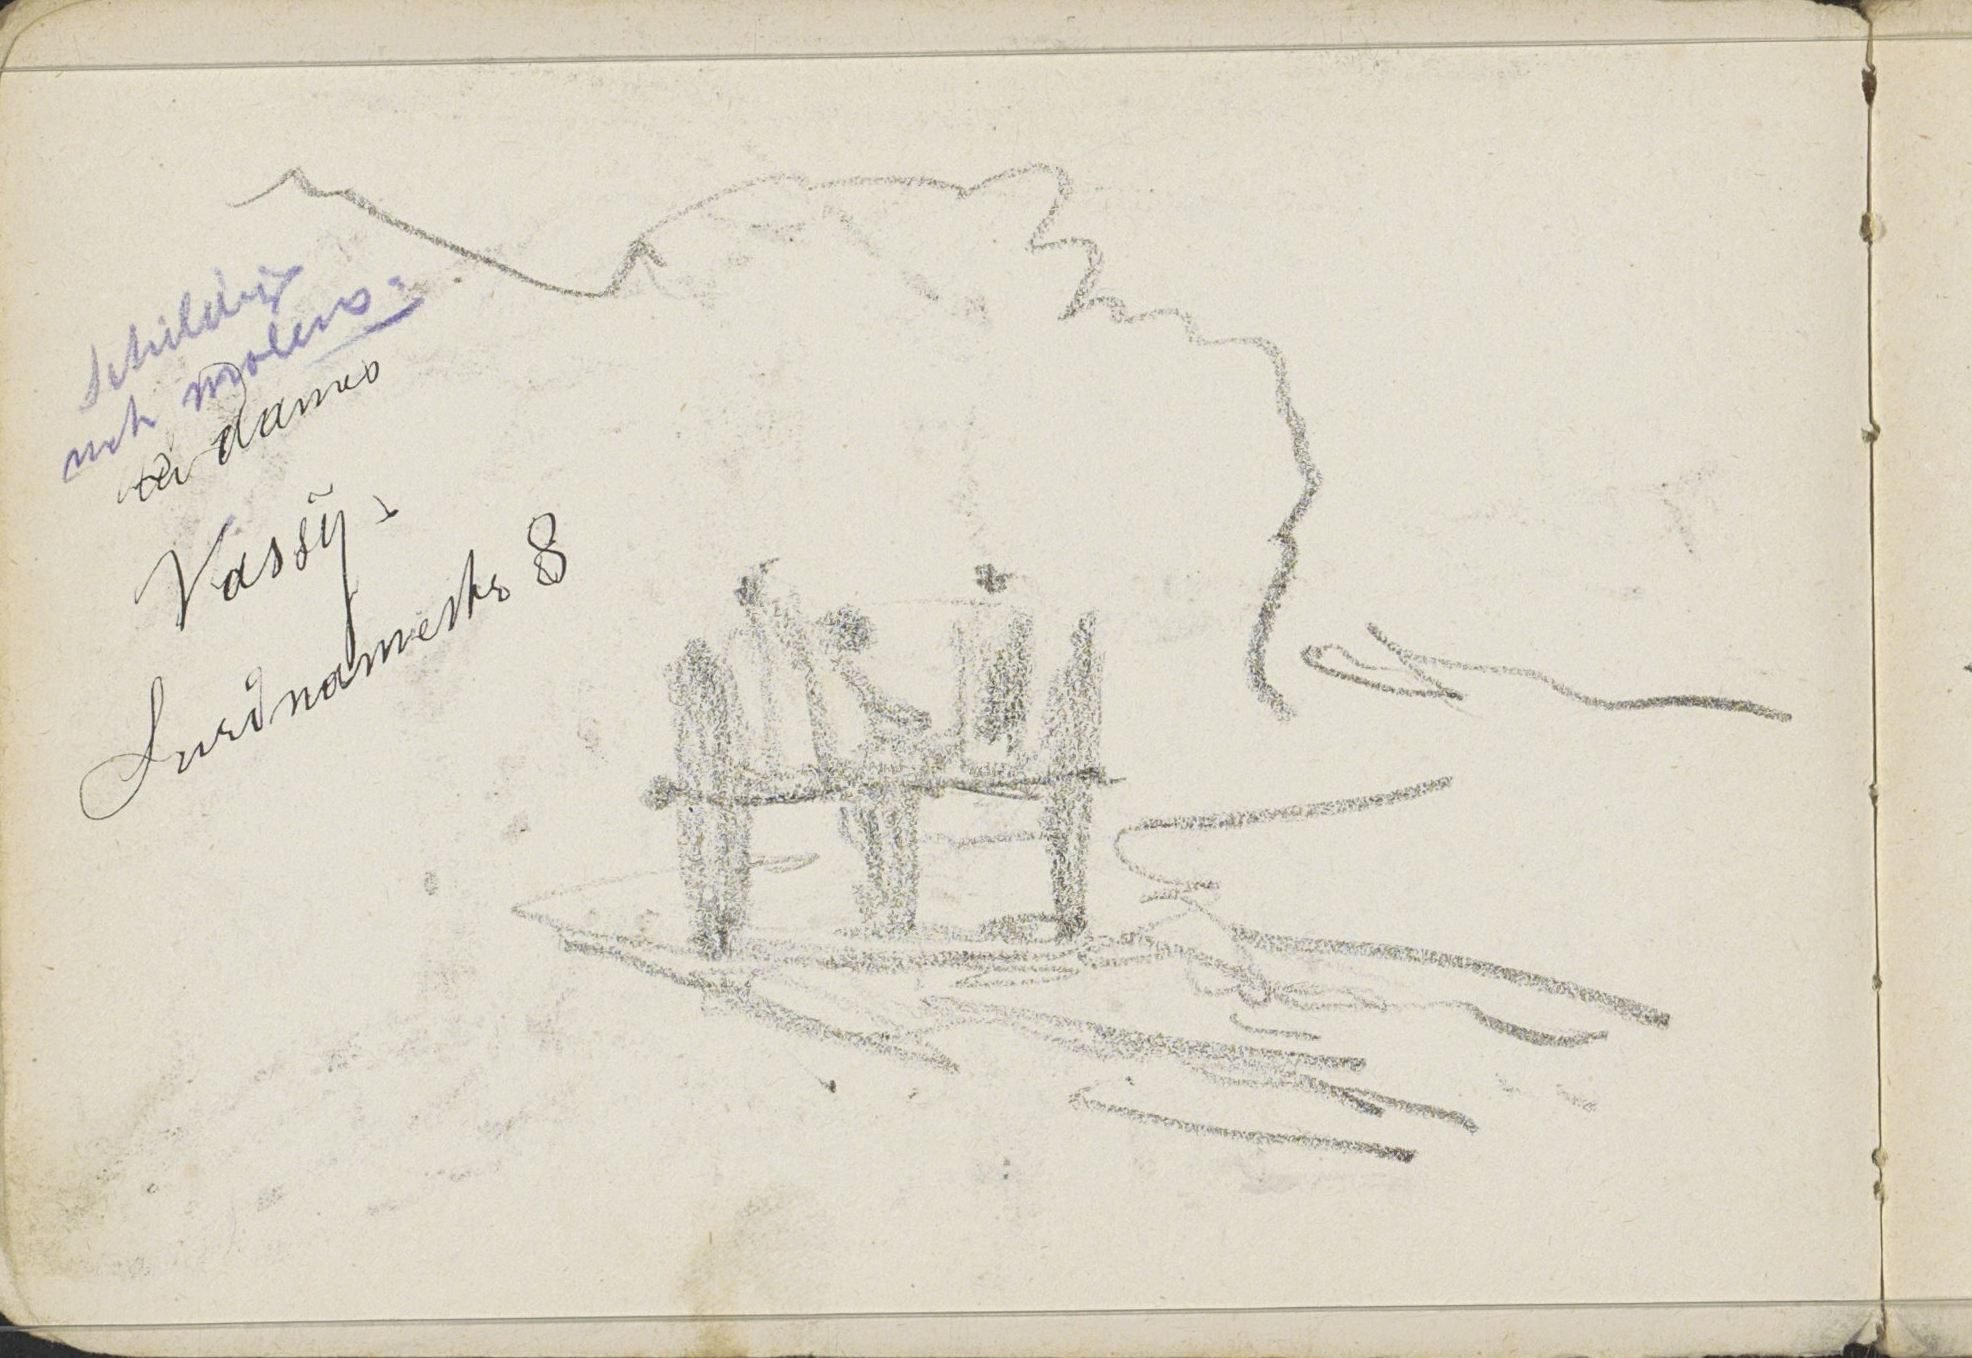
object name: sketchbook leaf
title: Figuren op een kar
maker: willem cornelis rip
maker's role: draughtsman, painter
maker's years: 1856-1922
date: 1905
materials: chalk, paper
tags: (farm) wagon, freight wagon, cart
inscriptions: annotation: ‘schilderij/ met molens/ [...] dames/ Vassij/ Surinamestr 8’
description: Blad 1 verso uit een schetsboek met 42 bladen.